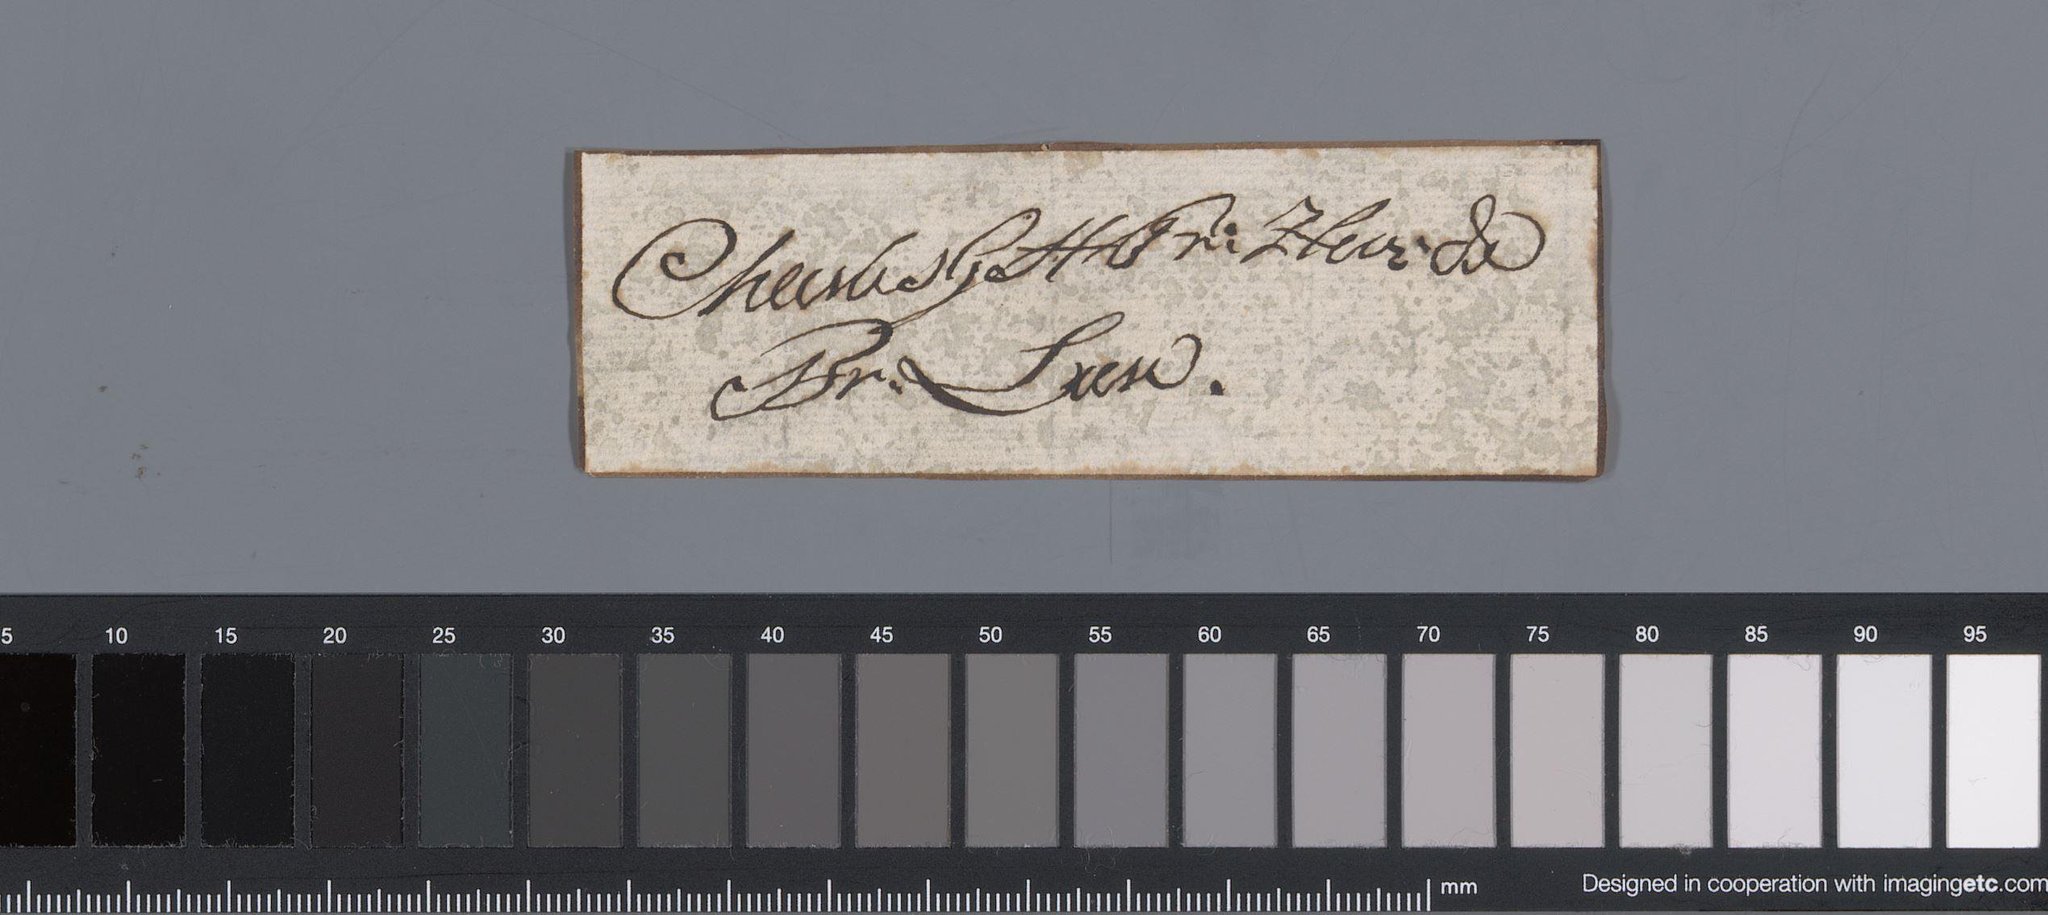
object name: sheet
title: Document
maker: karel van brunswijk-wolfenbüttel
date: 1770-1806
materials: ink, paper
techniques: writing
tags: karel van brunswijk-wolfenbüttel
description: Handtekening in bruine inkt (van Karel George August van Brunswijk-Wolffenbuttel), op blaadje papier. Gesigneerd: Charles G A Pr Herz de Br Lux (?).